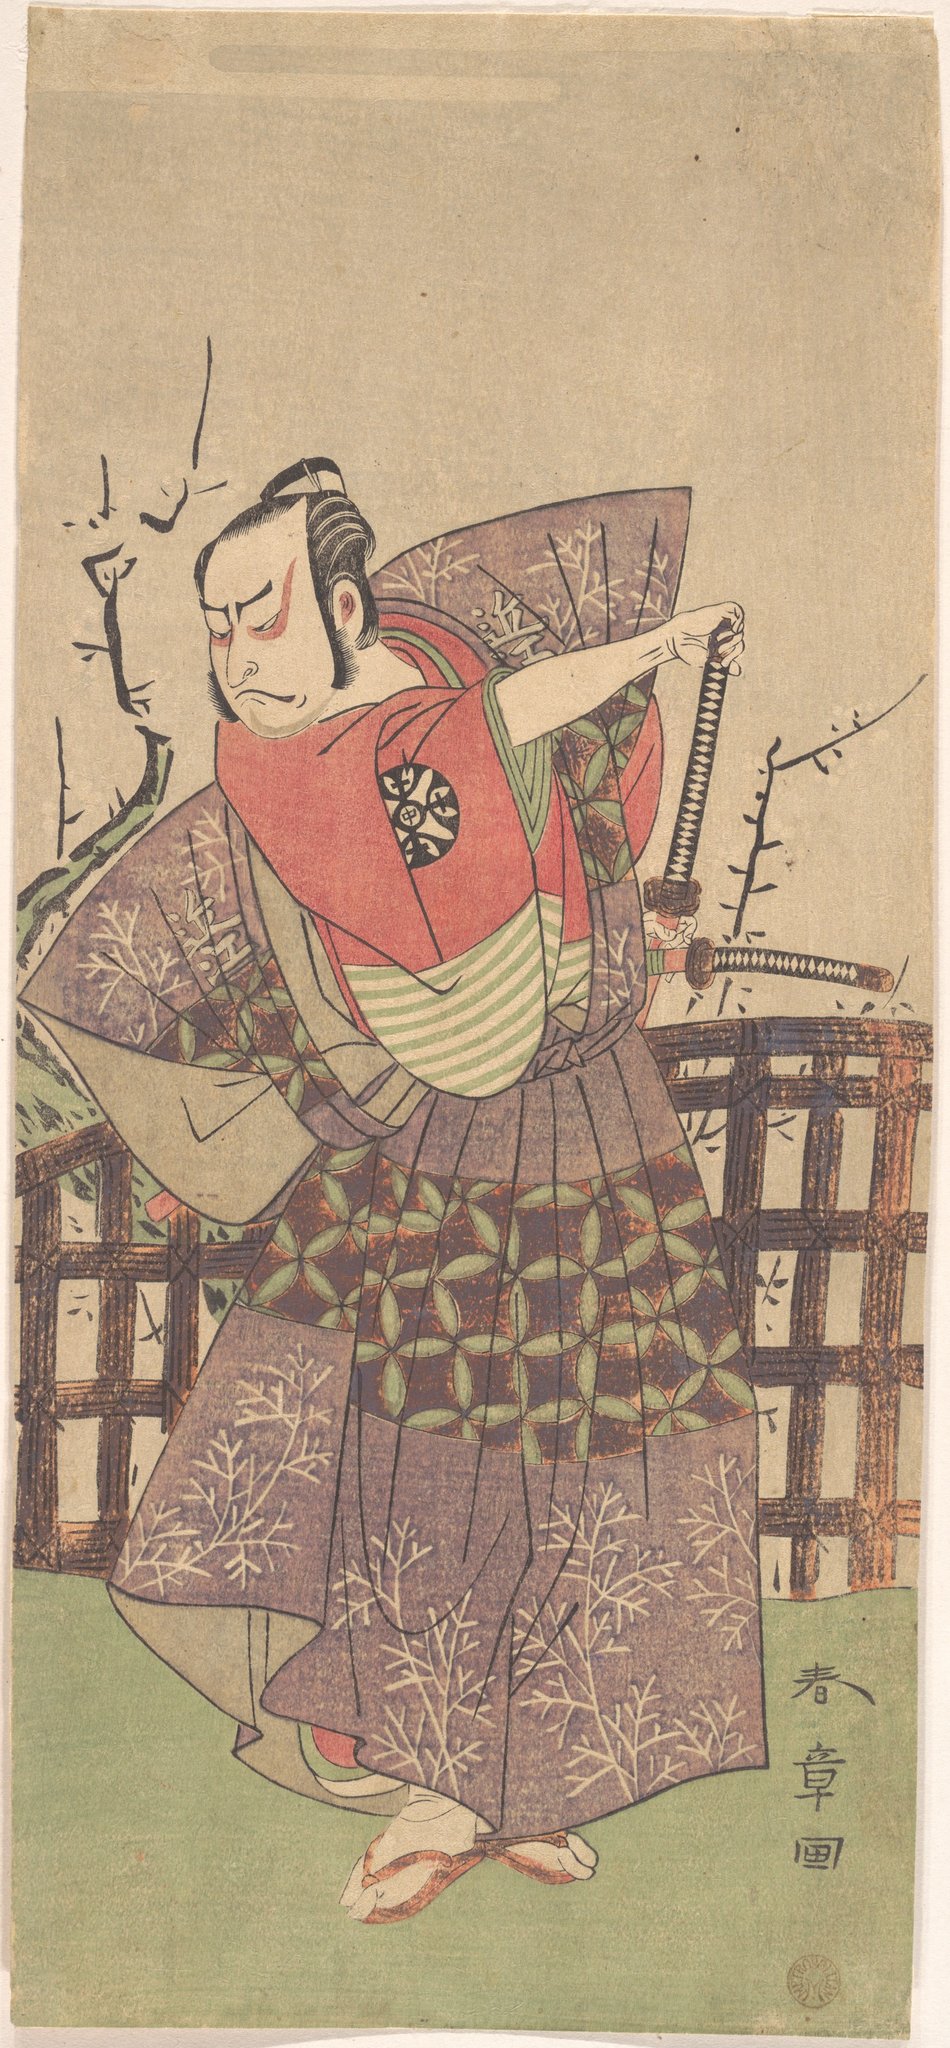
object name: woodblock print nishiki e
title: The First Nakamura Nakazo as a Samurai Dressed in Kamishimo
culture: japanese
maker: katsukawa shunshō 勝川春章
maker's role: artist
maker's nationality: japanese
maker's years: 1726-1792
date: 1775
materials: ink, paper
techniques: nishiki e, woodblock print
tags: swords,men,actors